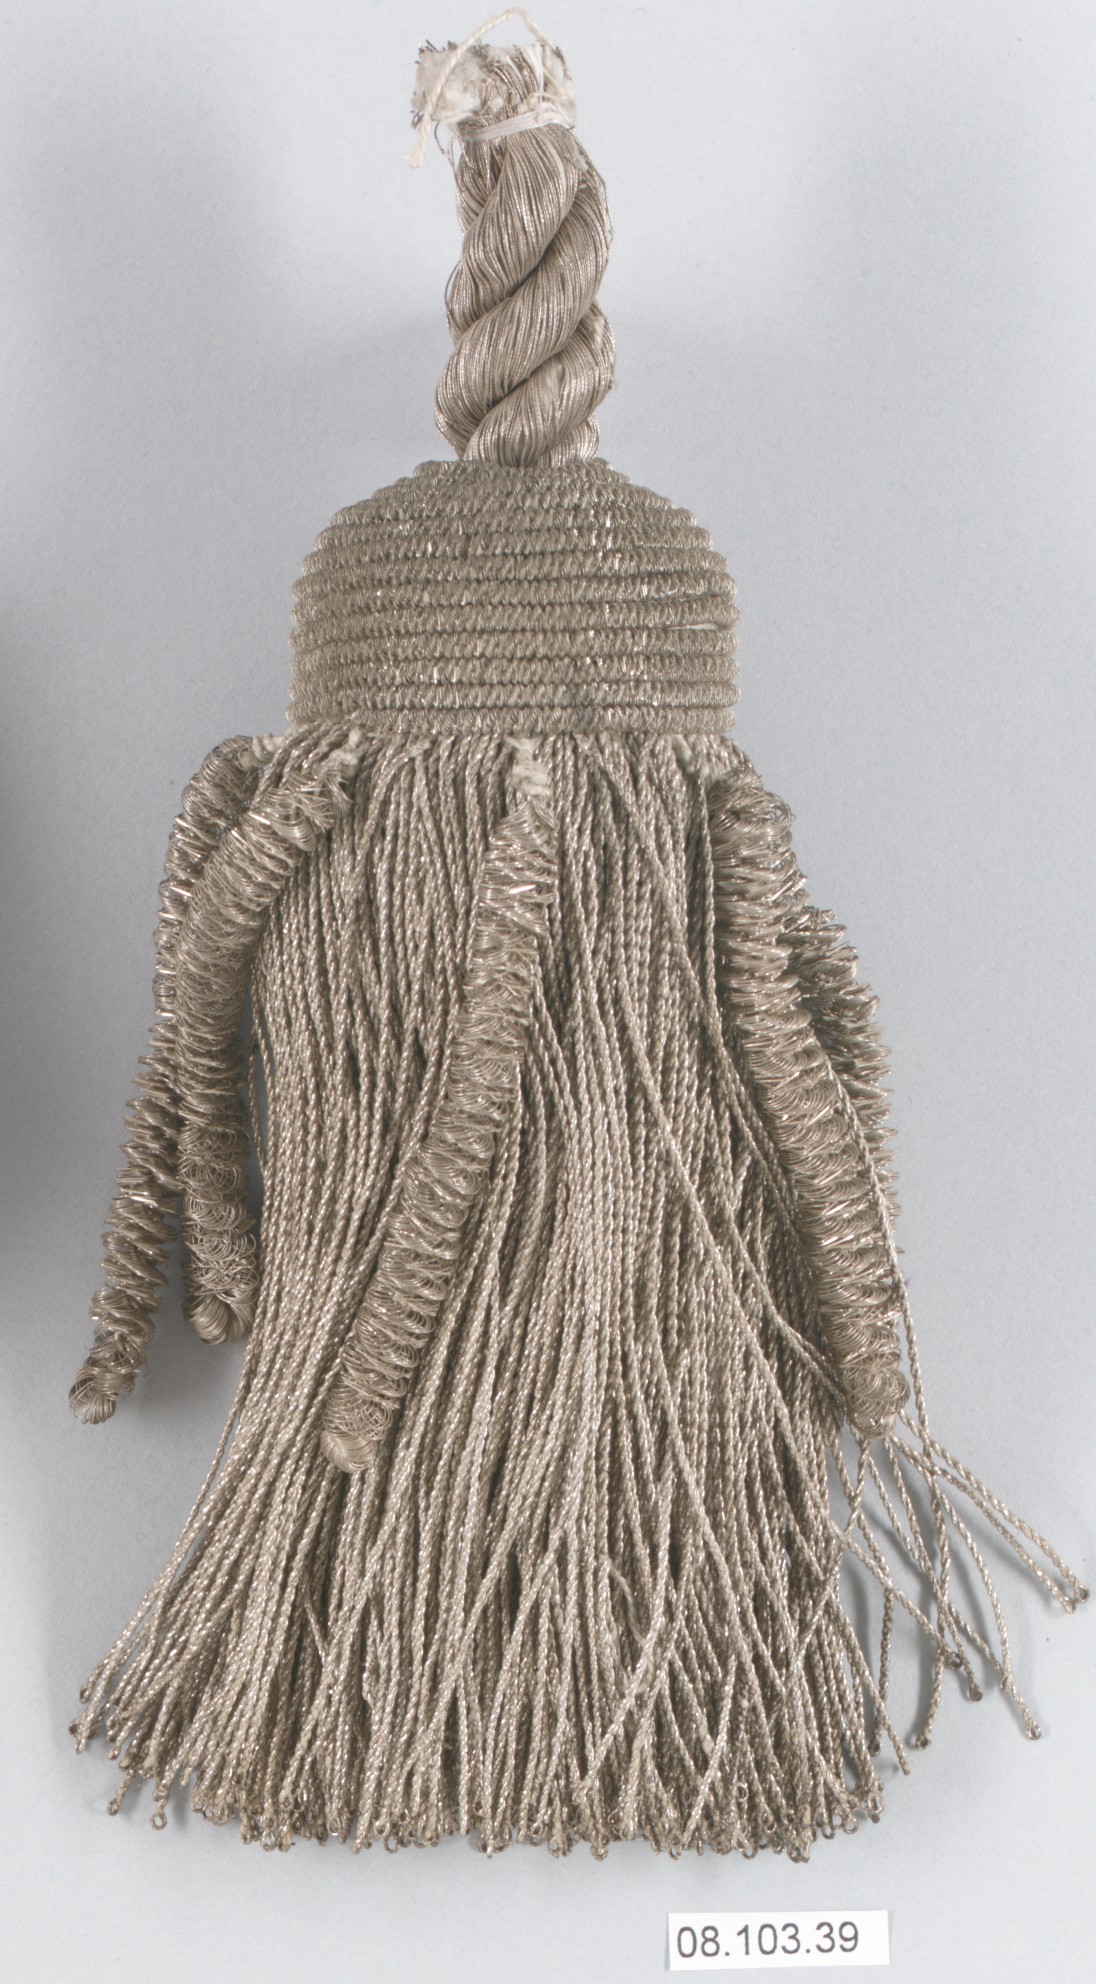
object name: tassel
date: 1701-1900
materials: metal thread